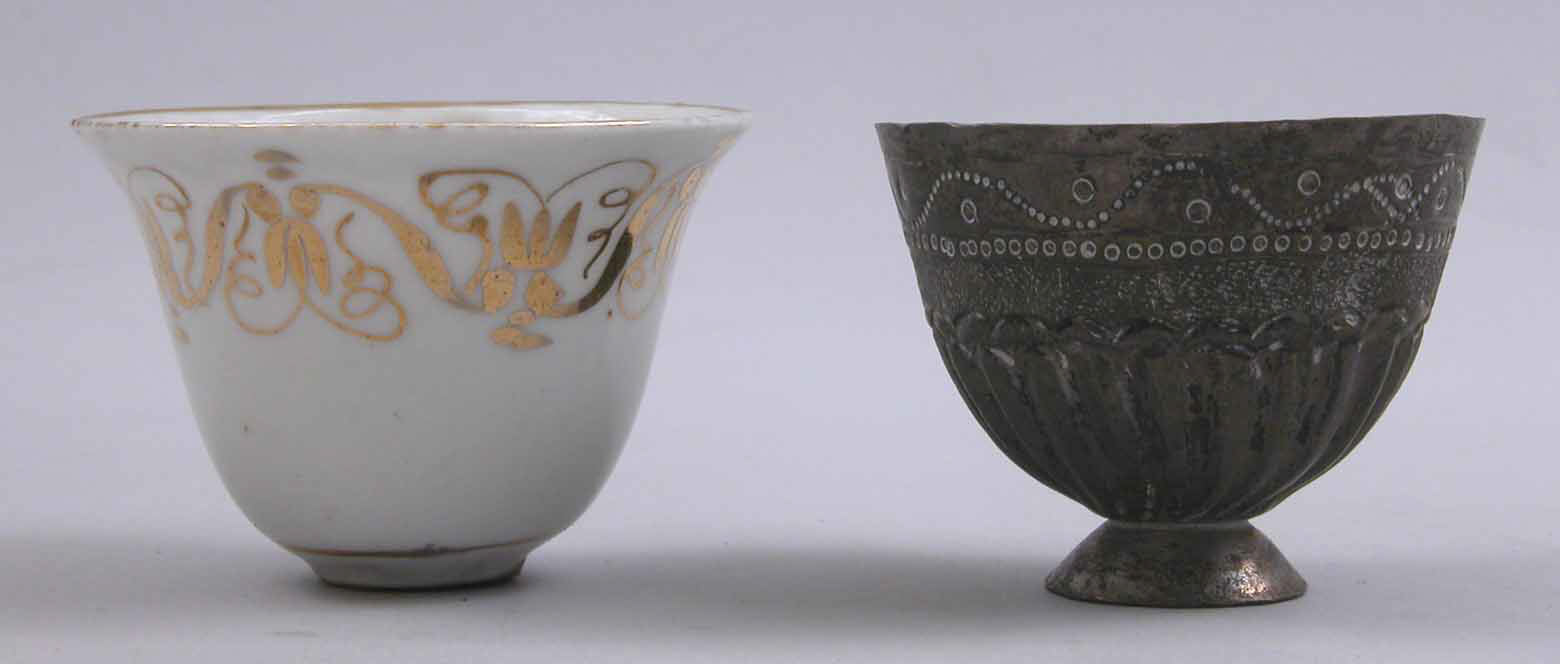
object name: cup holder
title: Cup and Holder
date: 1801-1900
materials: gold, porcelain, silver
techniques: glazing, painting, repoussé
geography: turkey